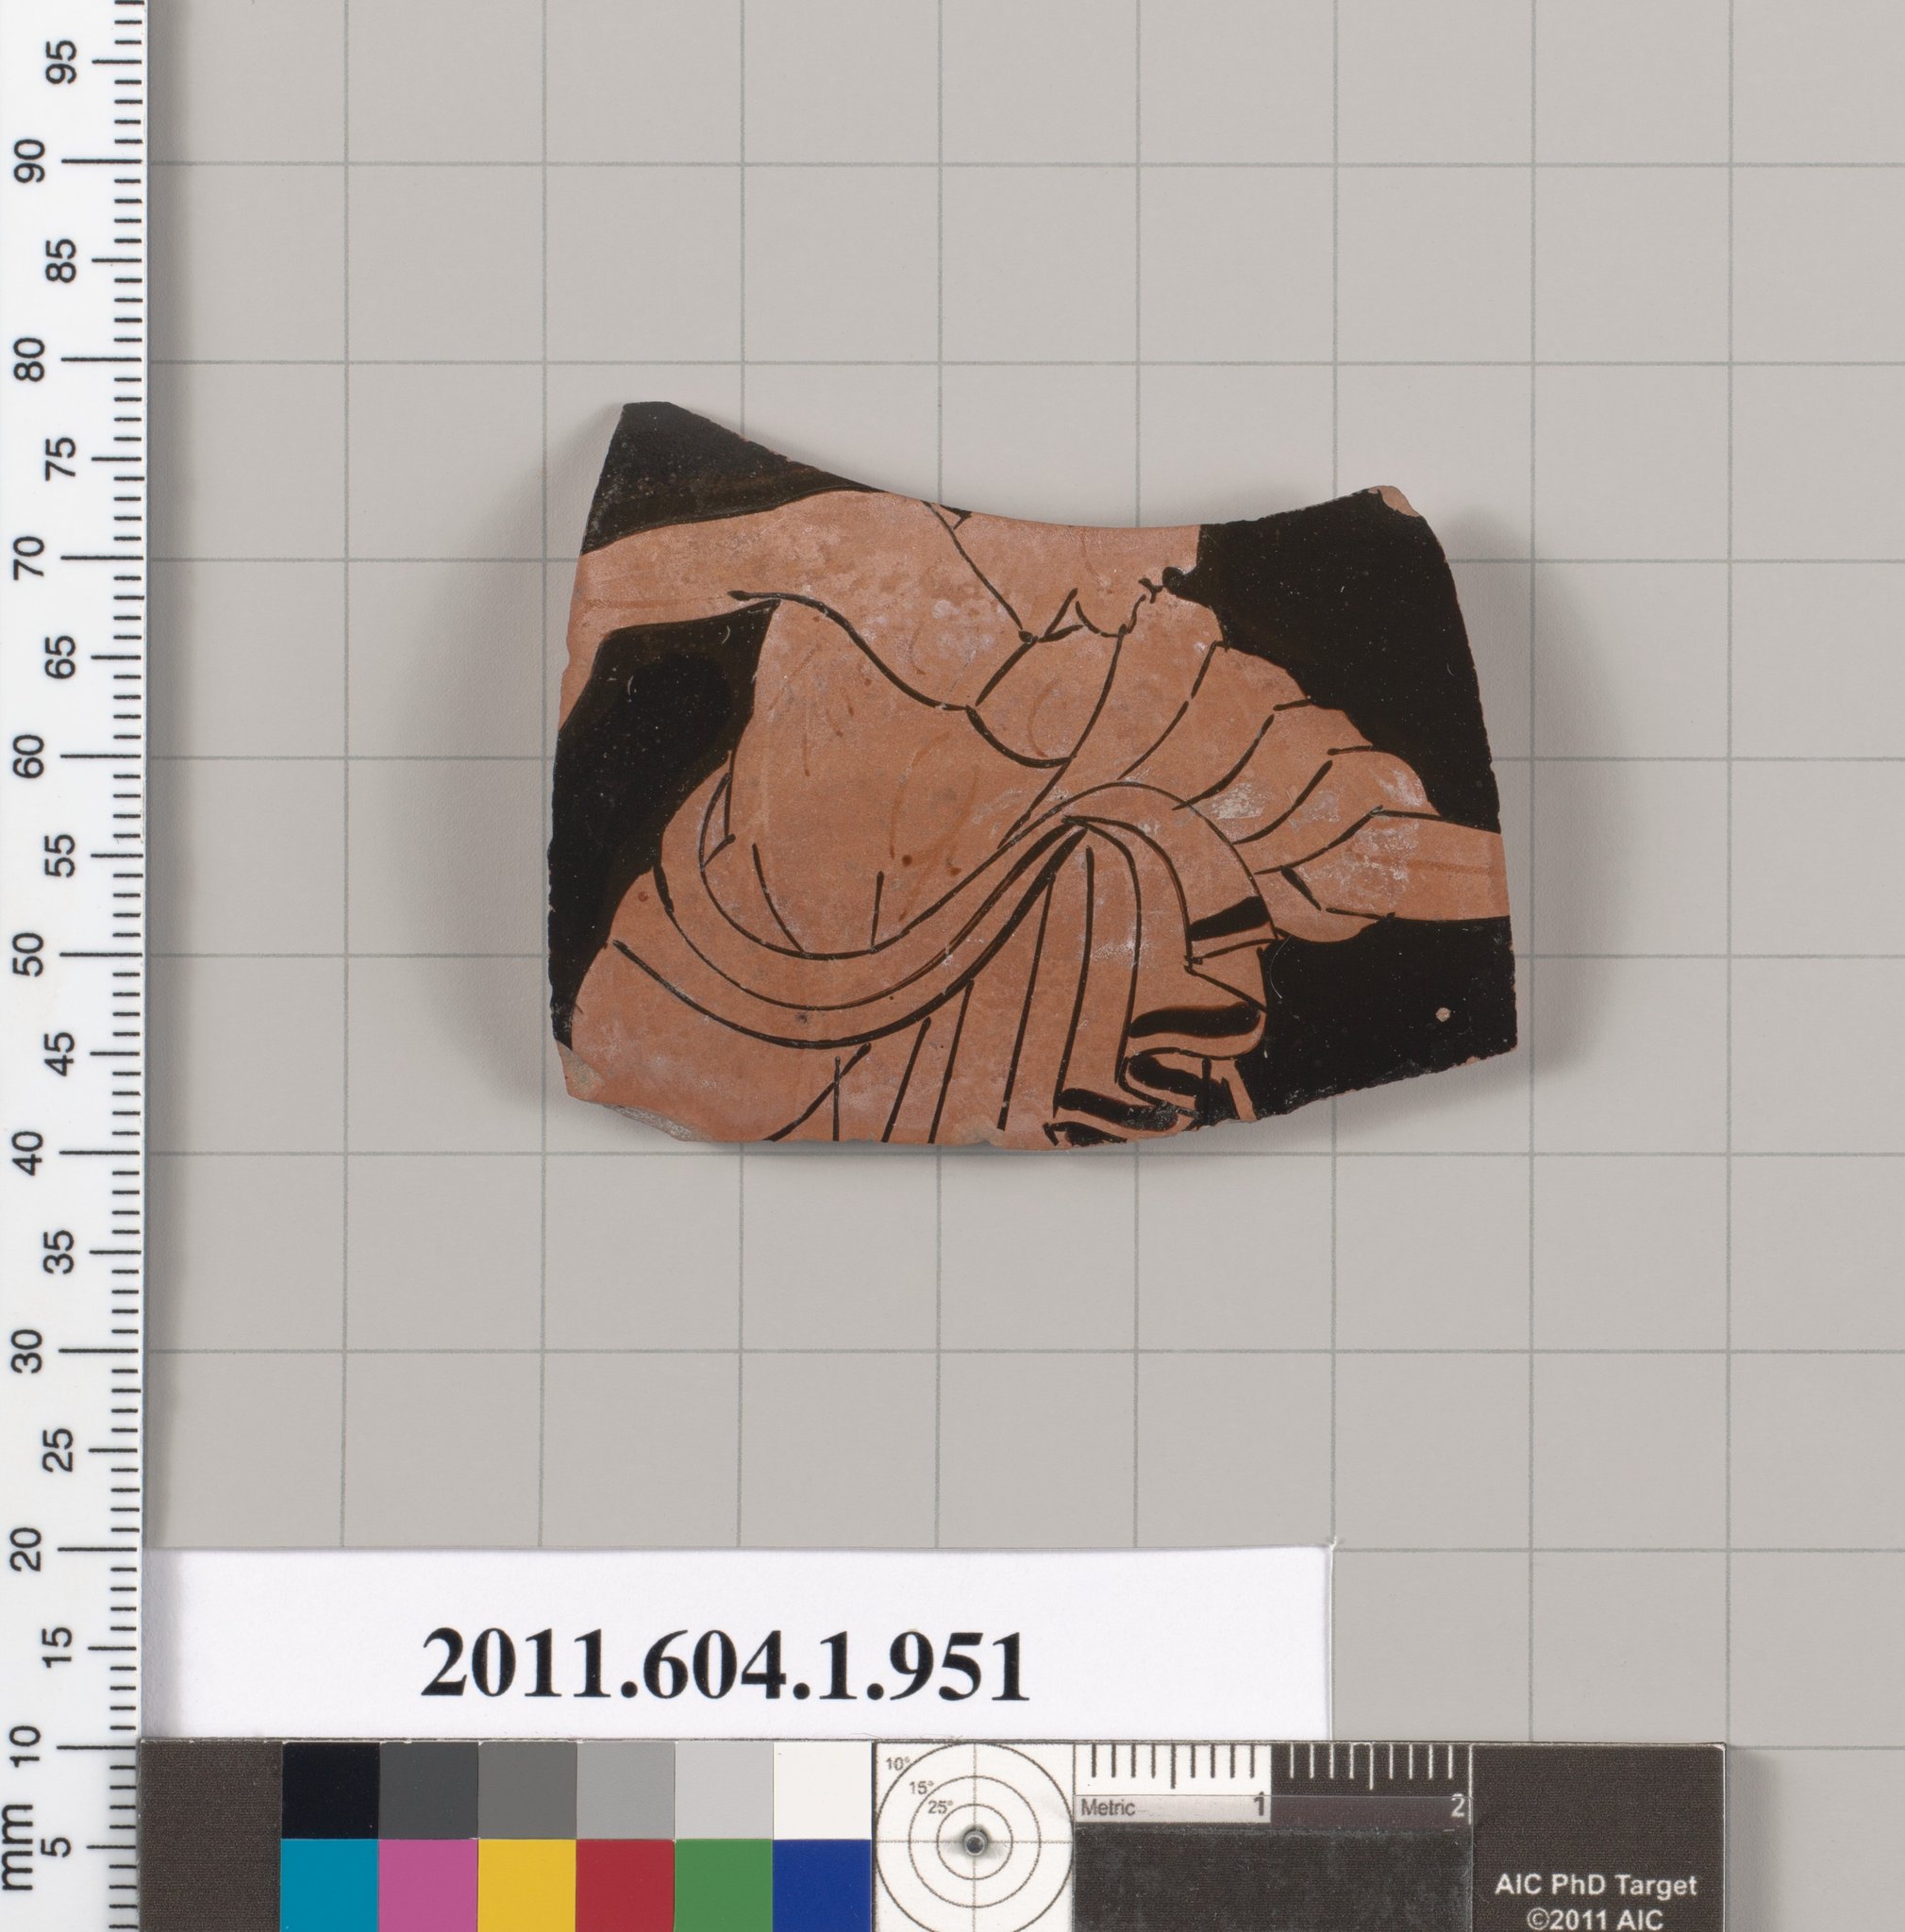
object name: kylix fragment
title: Terracotta fragment of a kylix (drinking cup)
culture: greek, attic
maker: foundry painter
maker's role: artist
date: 490-480 BCE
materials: terracotta